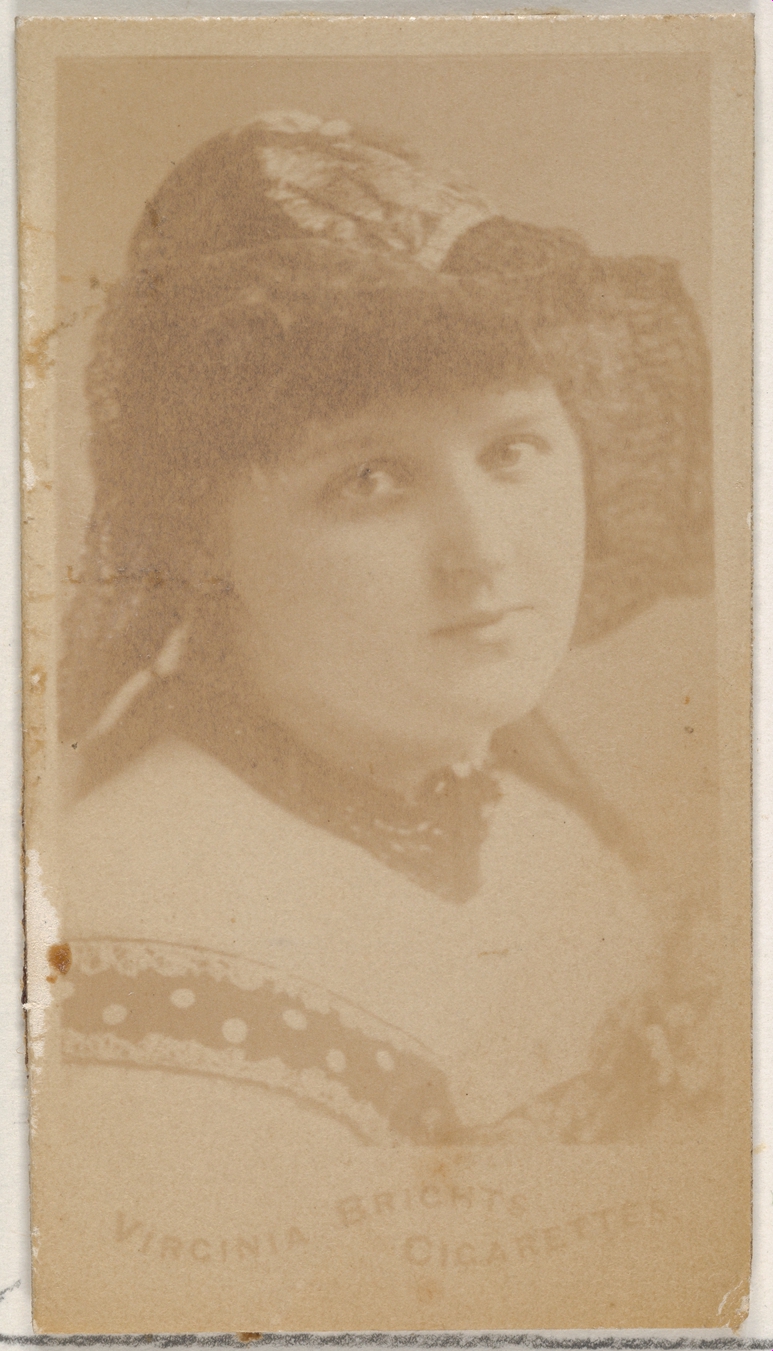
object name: photograph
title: From the Actors and Actresses series (N45, Type 5) for Virginia Brights Cigarettes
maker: allen & ginter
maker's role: publisher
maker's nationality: american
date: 1888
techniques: albumen silver print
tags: portraits,women,actresses